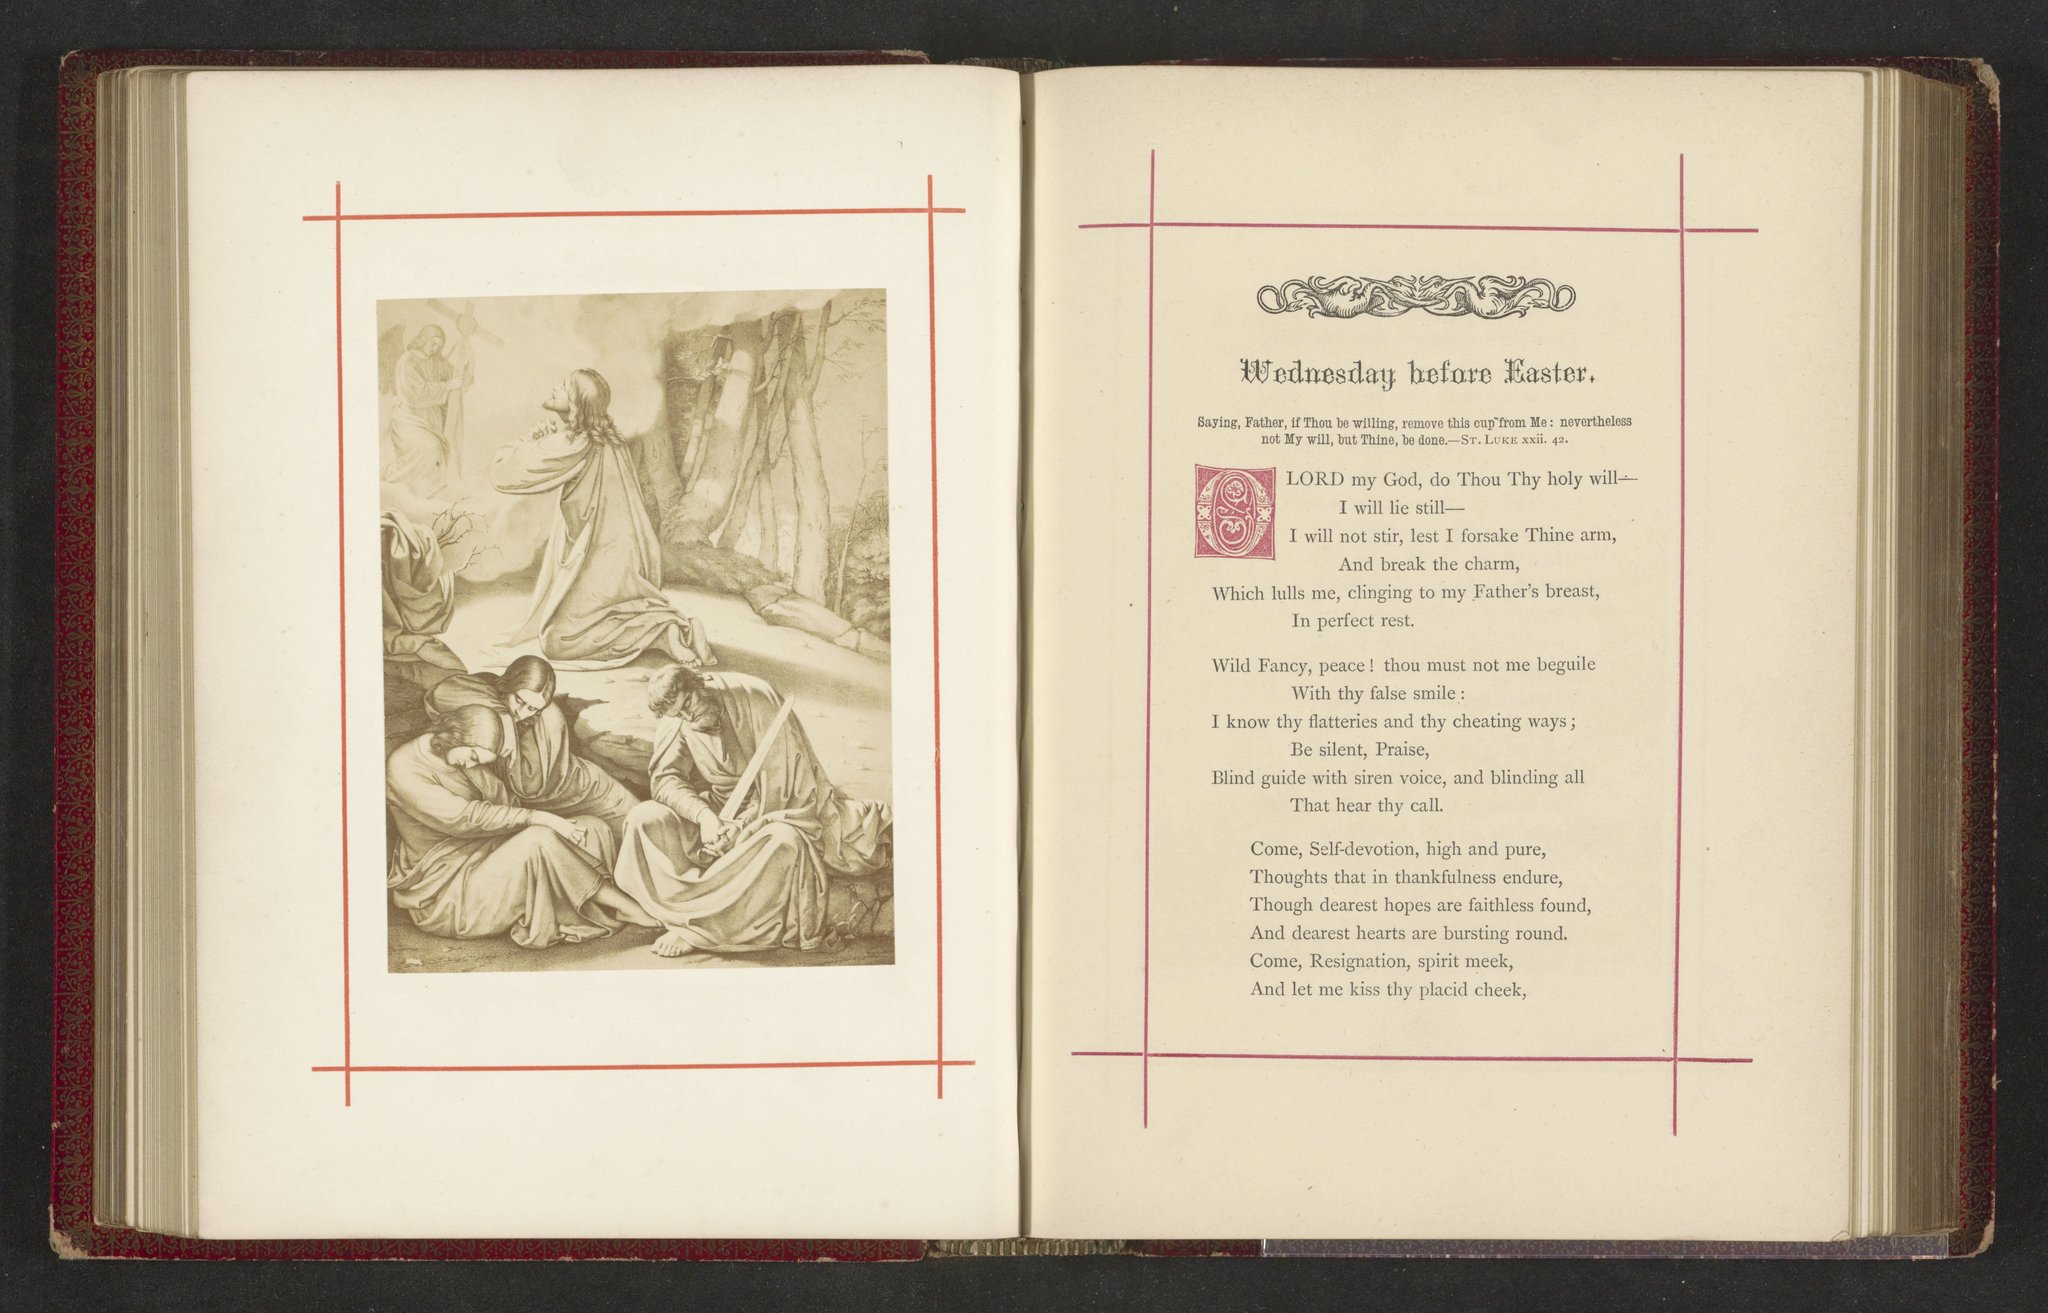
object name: photograph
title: Fotoreproductie van een prent, voorstellende het gebed van Christus in de tuin van Gethsemane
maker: Anonymous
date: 1868-1873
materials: photographic support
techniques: albumen print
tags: christ's prayer in the garden of gethsemane during the night